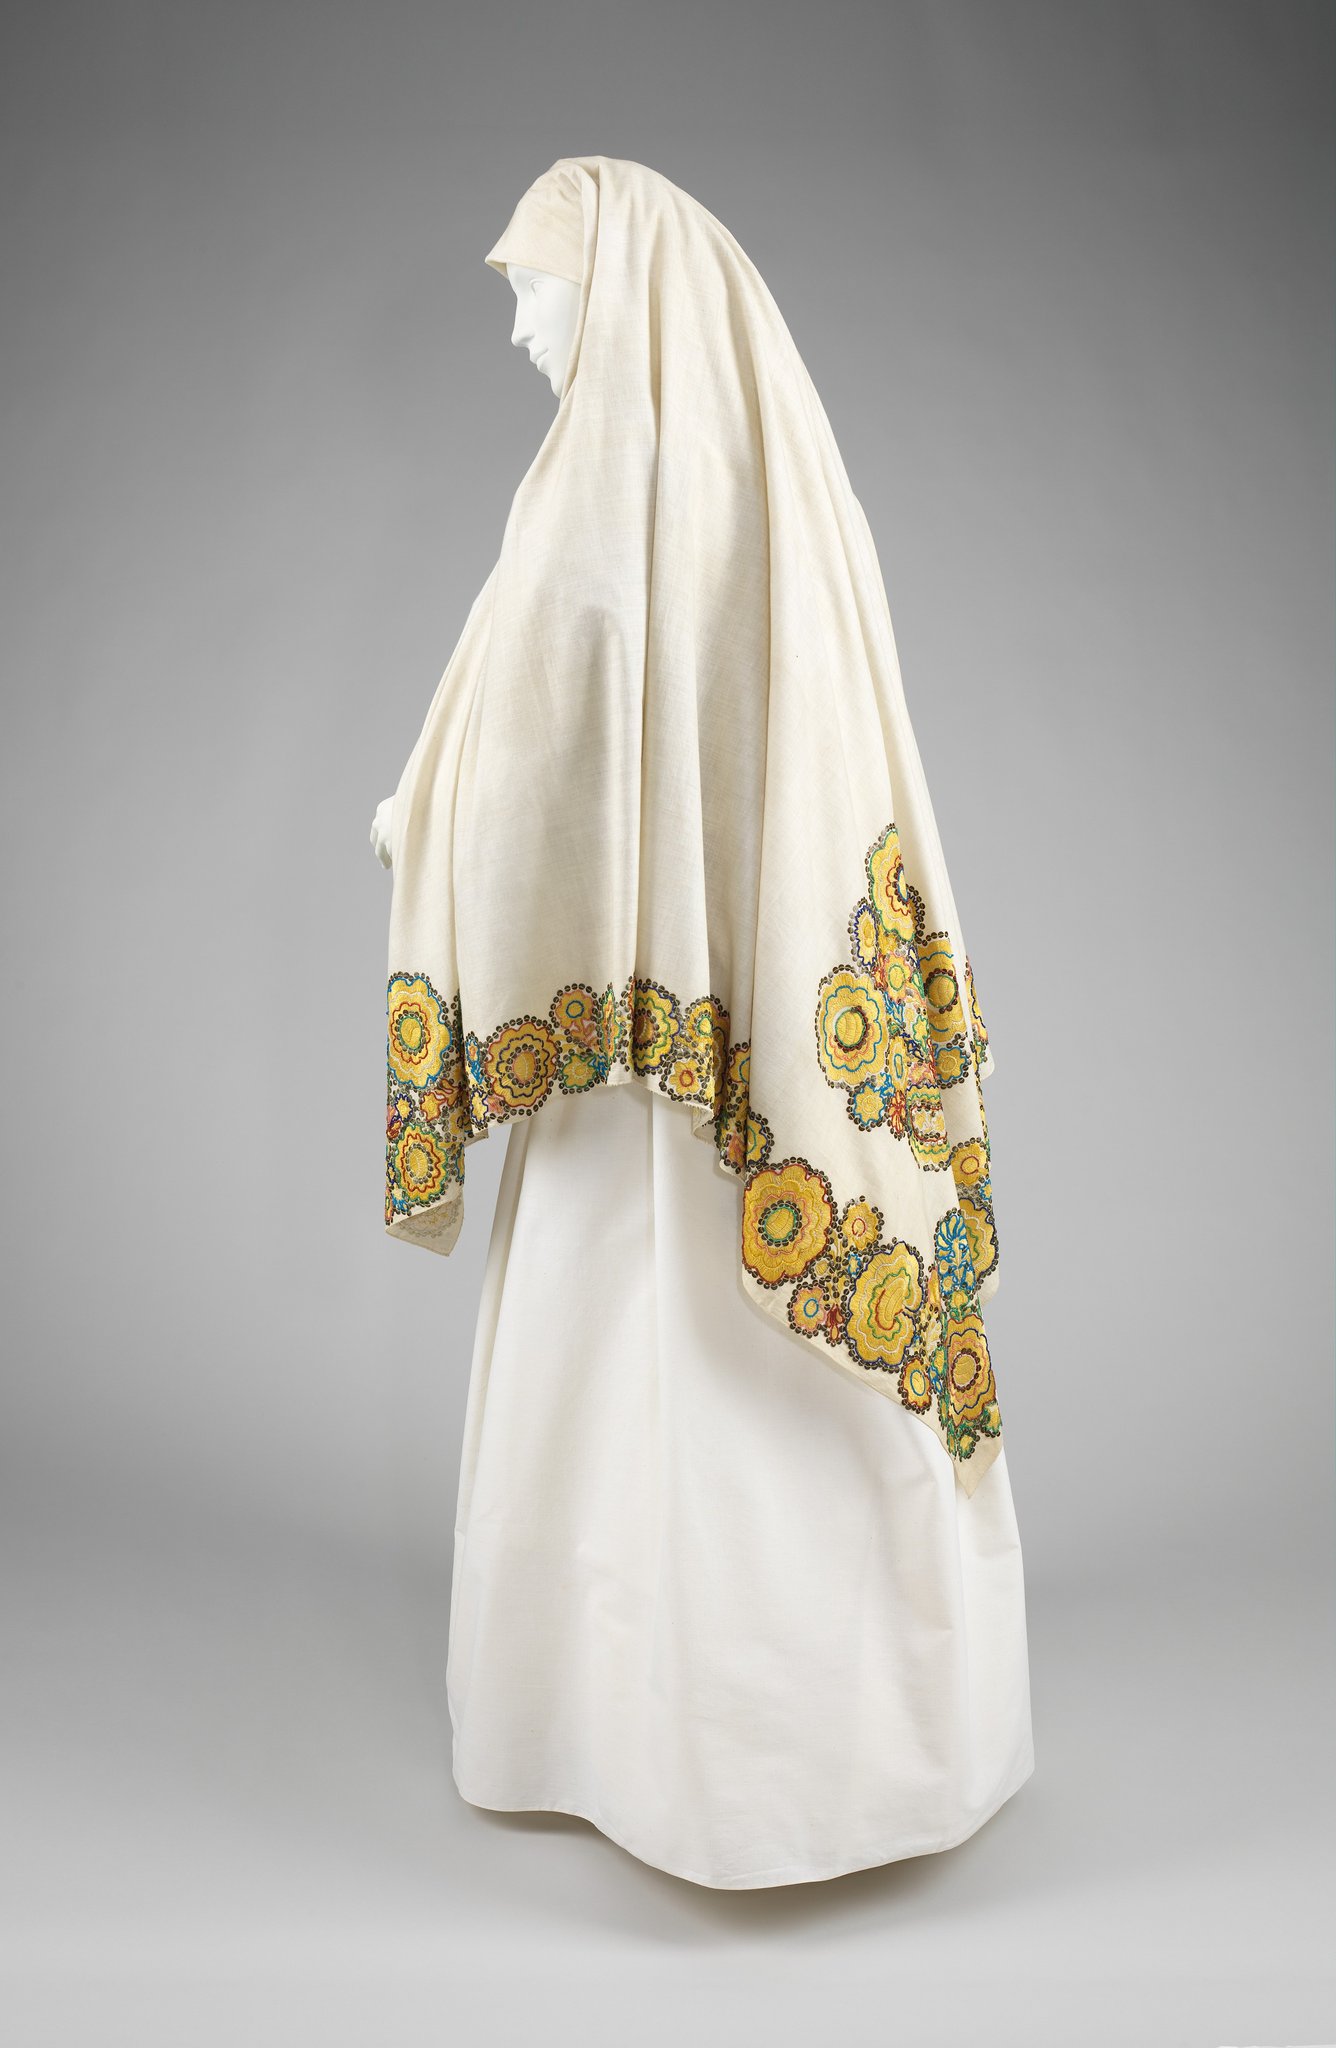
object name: wedding veil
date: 1867-1900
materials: glass, linen, metal, silk